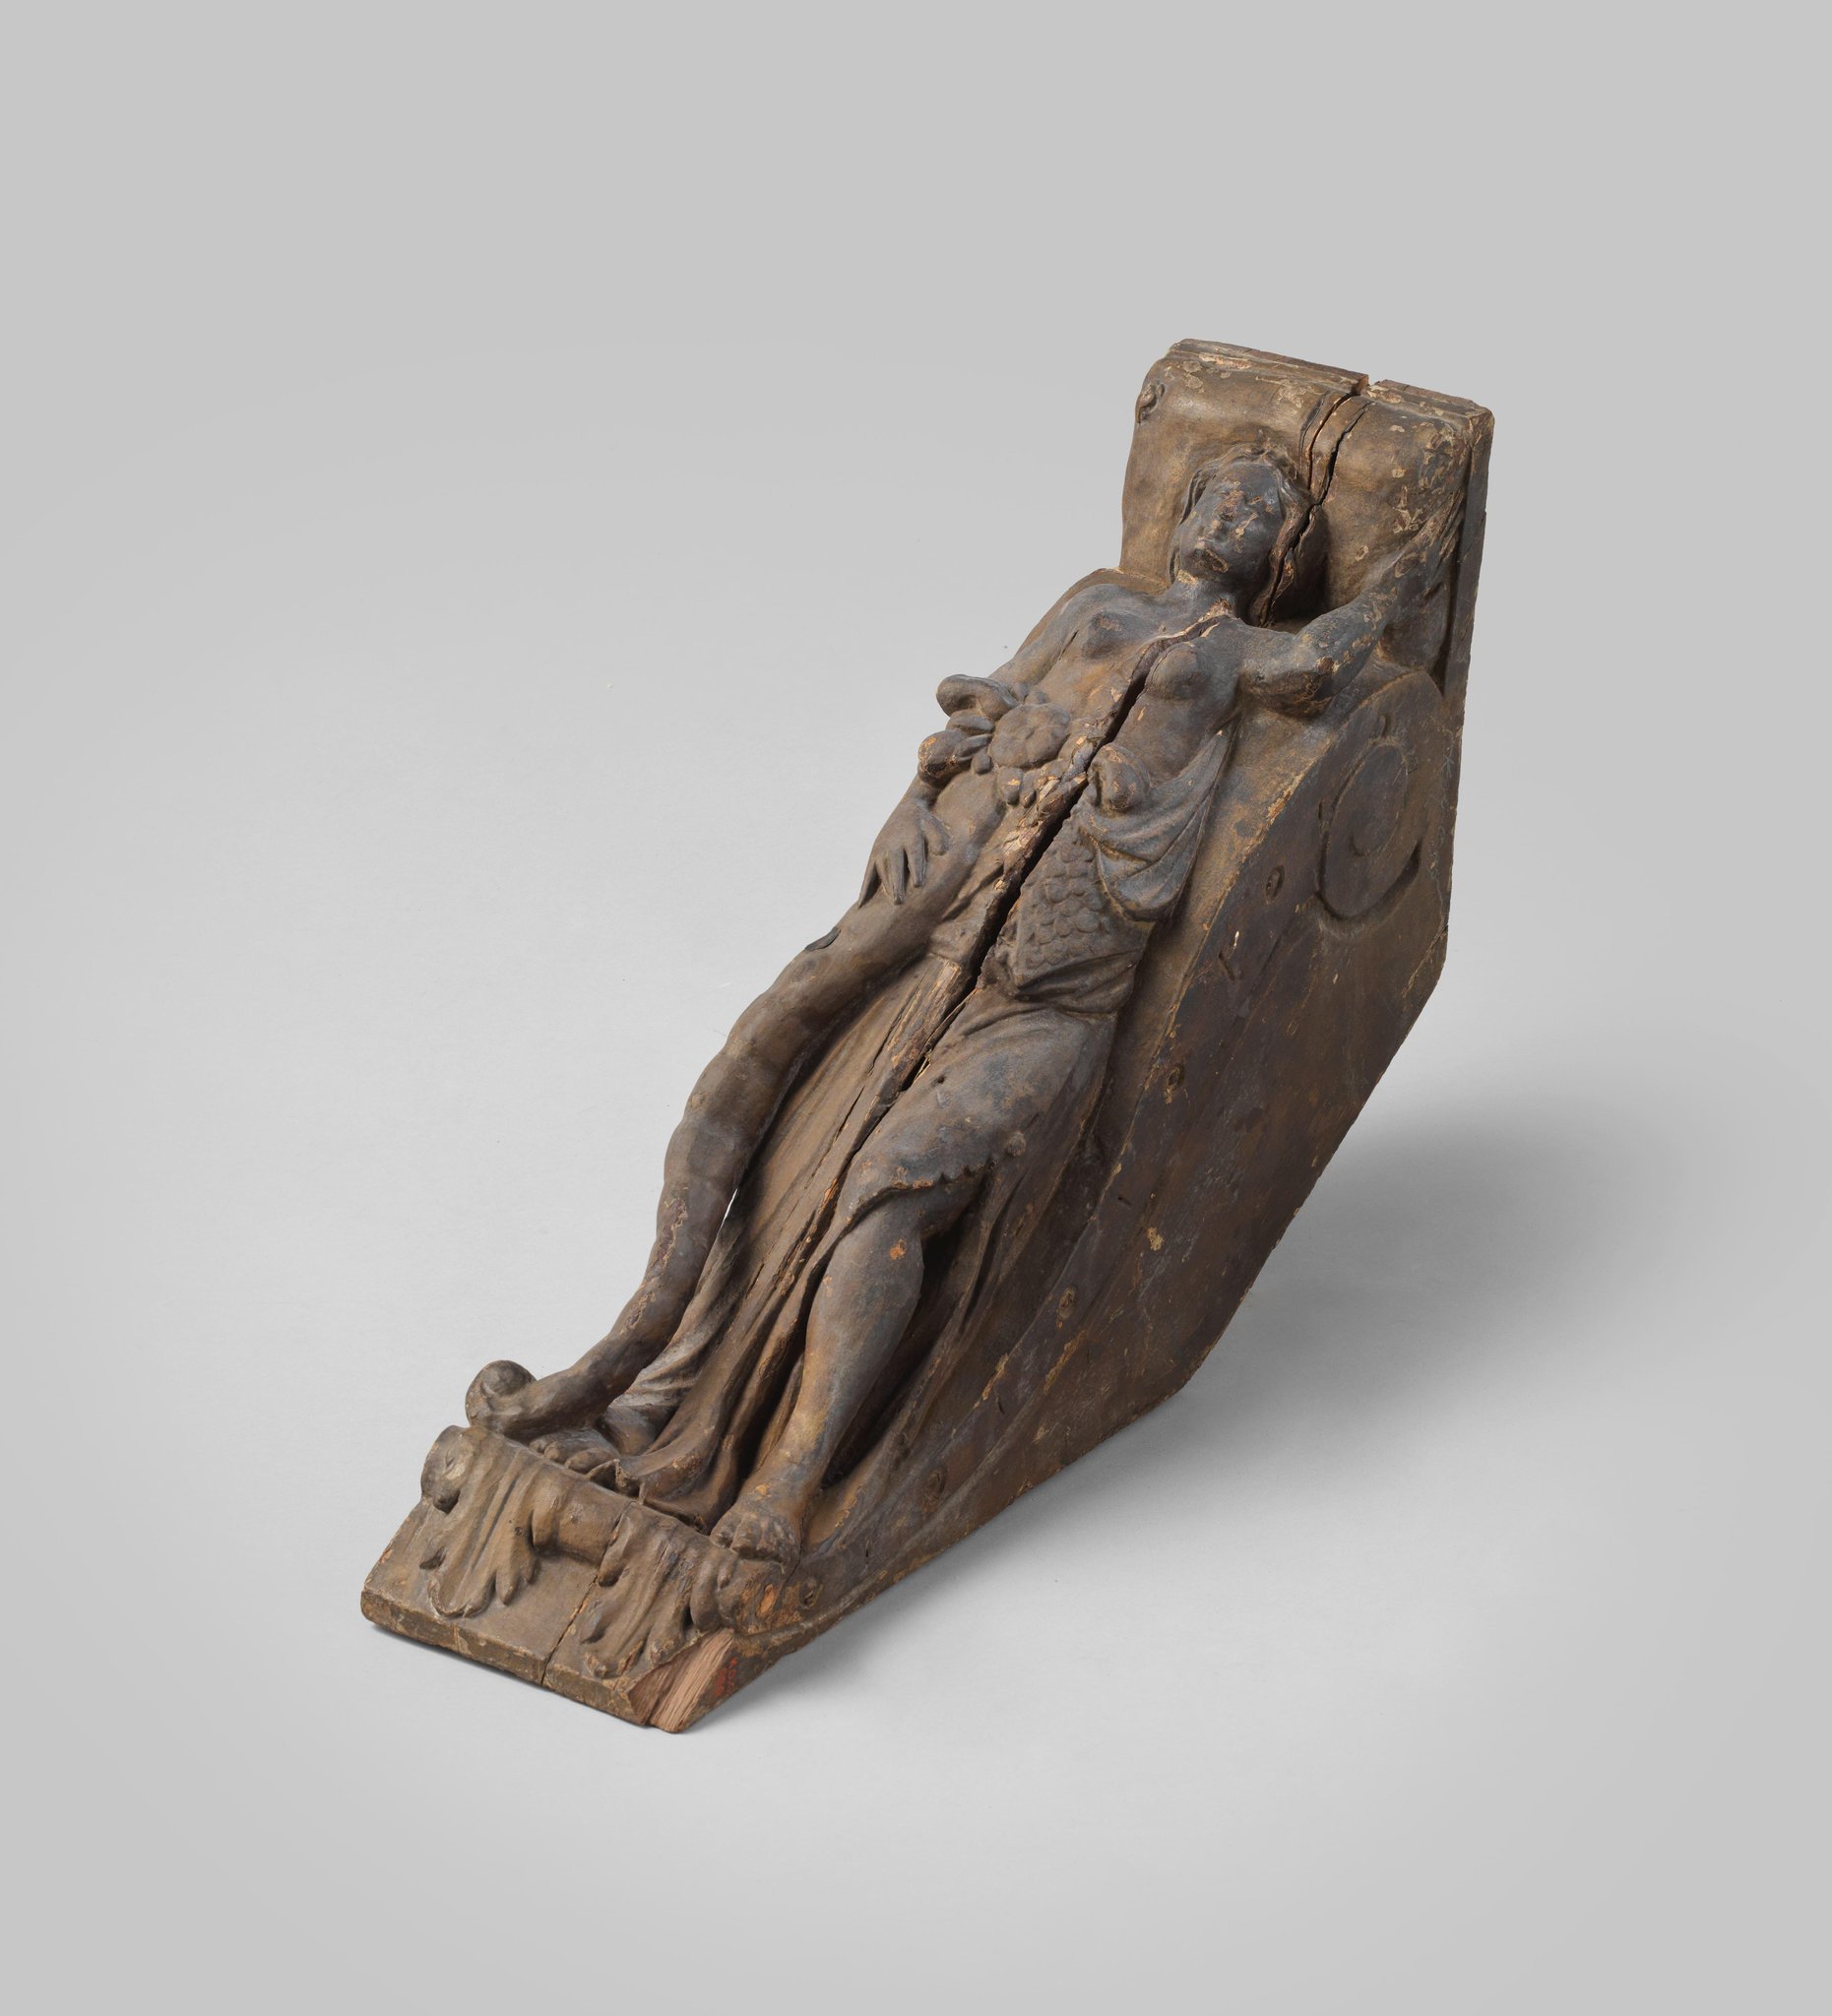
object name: korbeel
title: Korbeel van eikenhout waarop een vrouw in gedrapeerd gewaad, met hoorn des overvloeds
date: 1550-1600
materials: wood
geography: northern netherlands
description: Korbeel van eikenhout. Op het consolevormige voorstuk is in reliëf een vrouw in een gedrapeerd gewaad en met een hoorn des overvloeds, staande op een acanthusblad, gebeeldhouwd. Afkomstig van een huis in de Mandenmakerssteeg te Amsterdam.